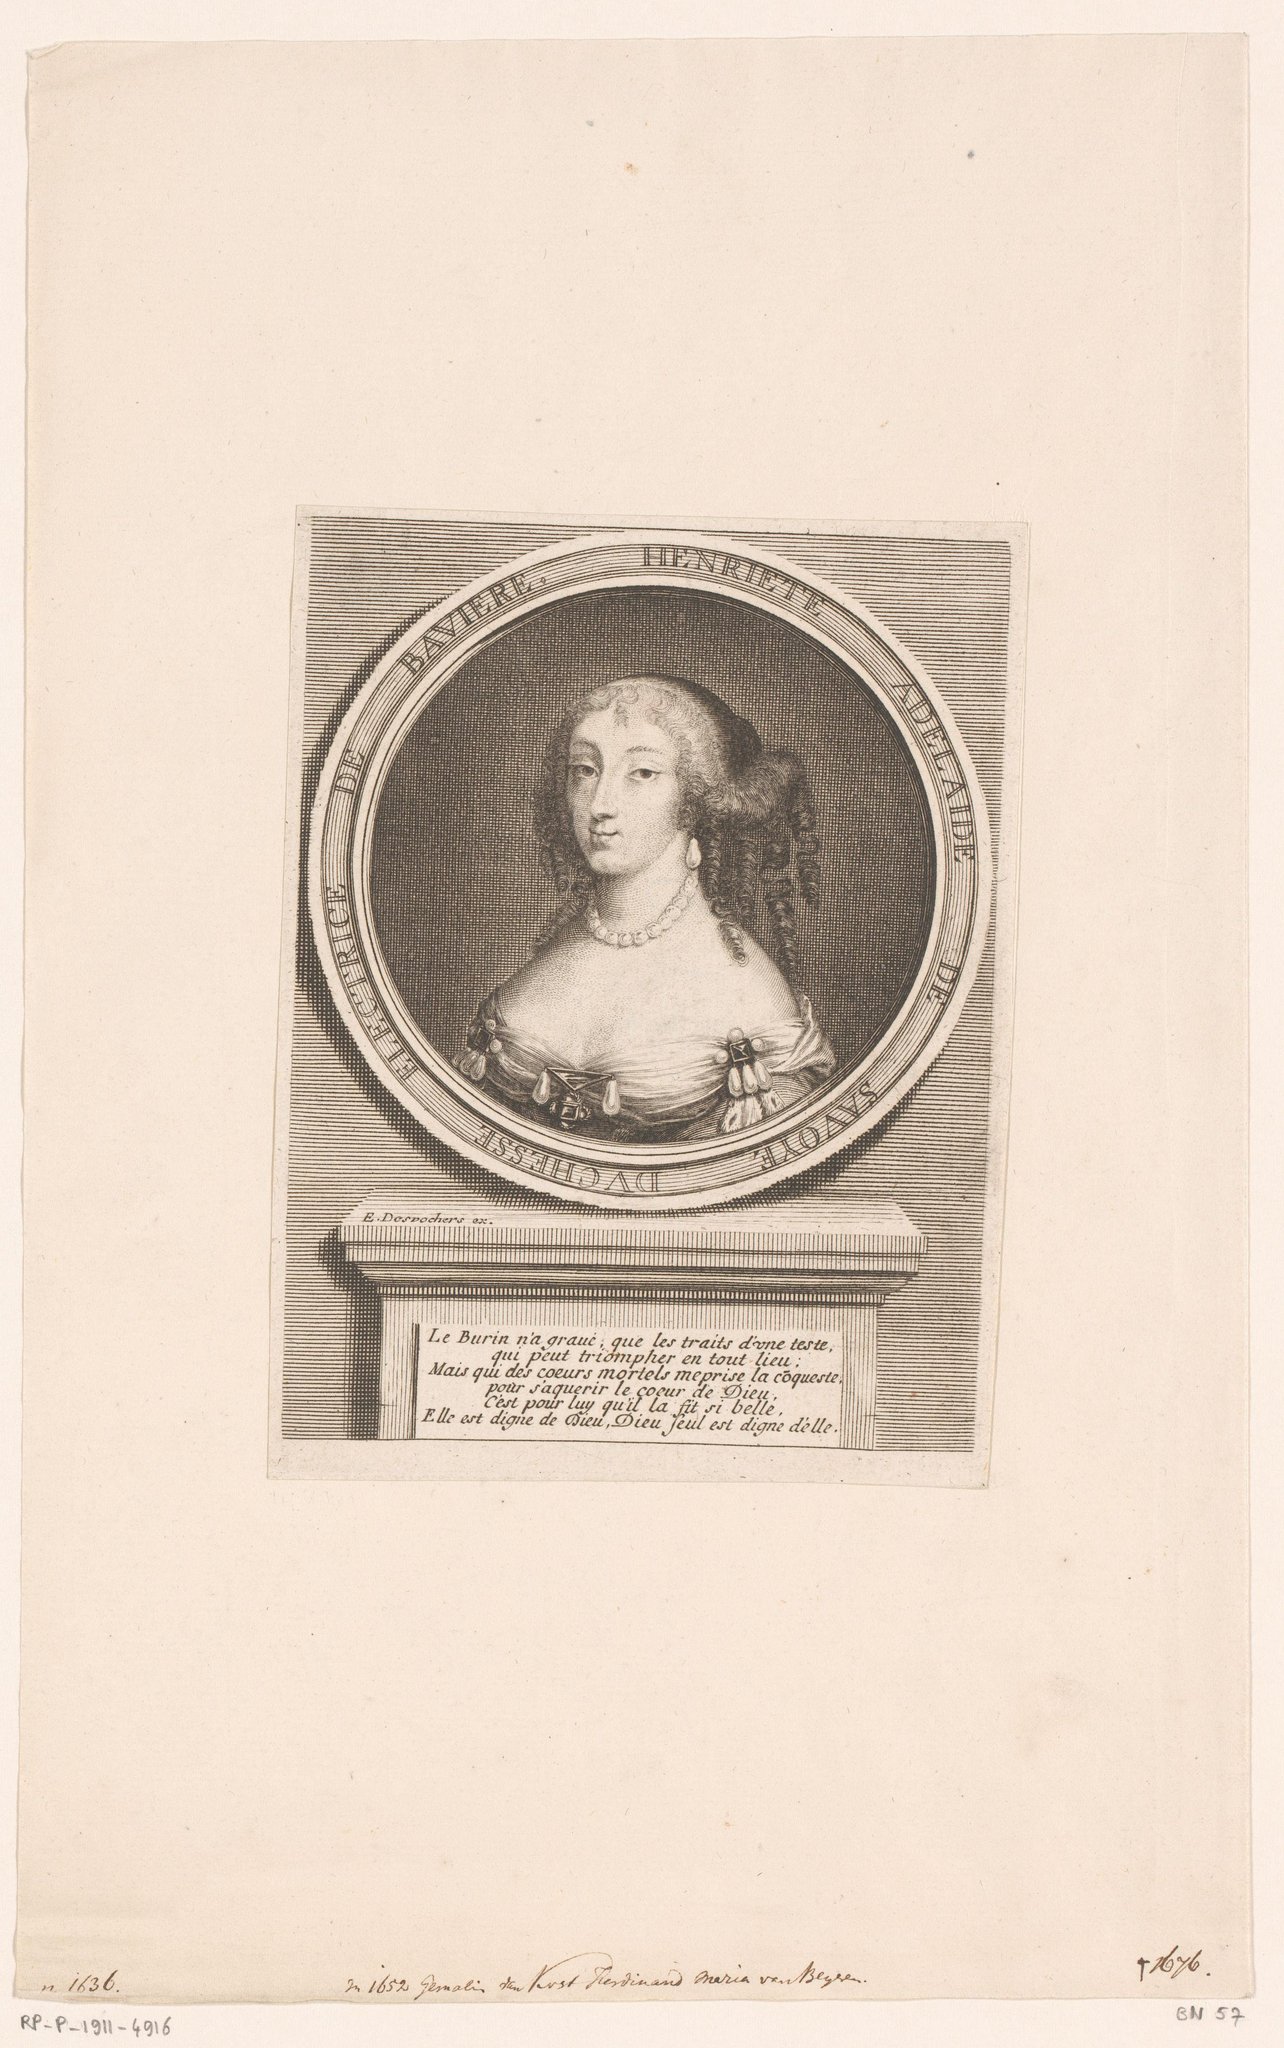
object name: print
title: Portret van Henriëtte Adelheid van Savoye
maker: étienne desrochers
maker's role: print maker, publisher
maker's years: 1668-1741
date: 1678-1741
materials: paper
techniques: engraving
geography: paris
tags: henriëtte adelheid van savoye, historical persons, princess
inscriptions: collector's mark: Lugt 2228